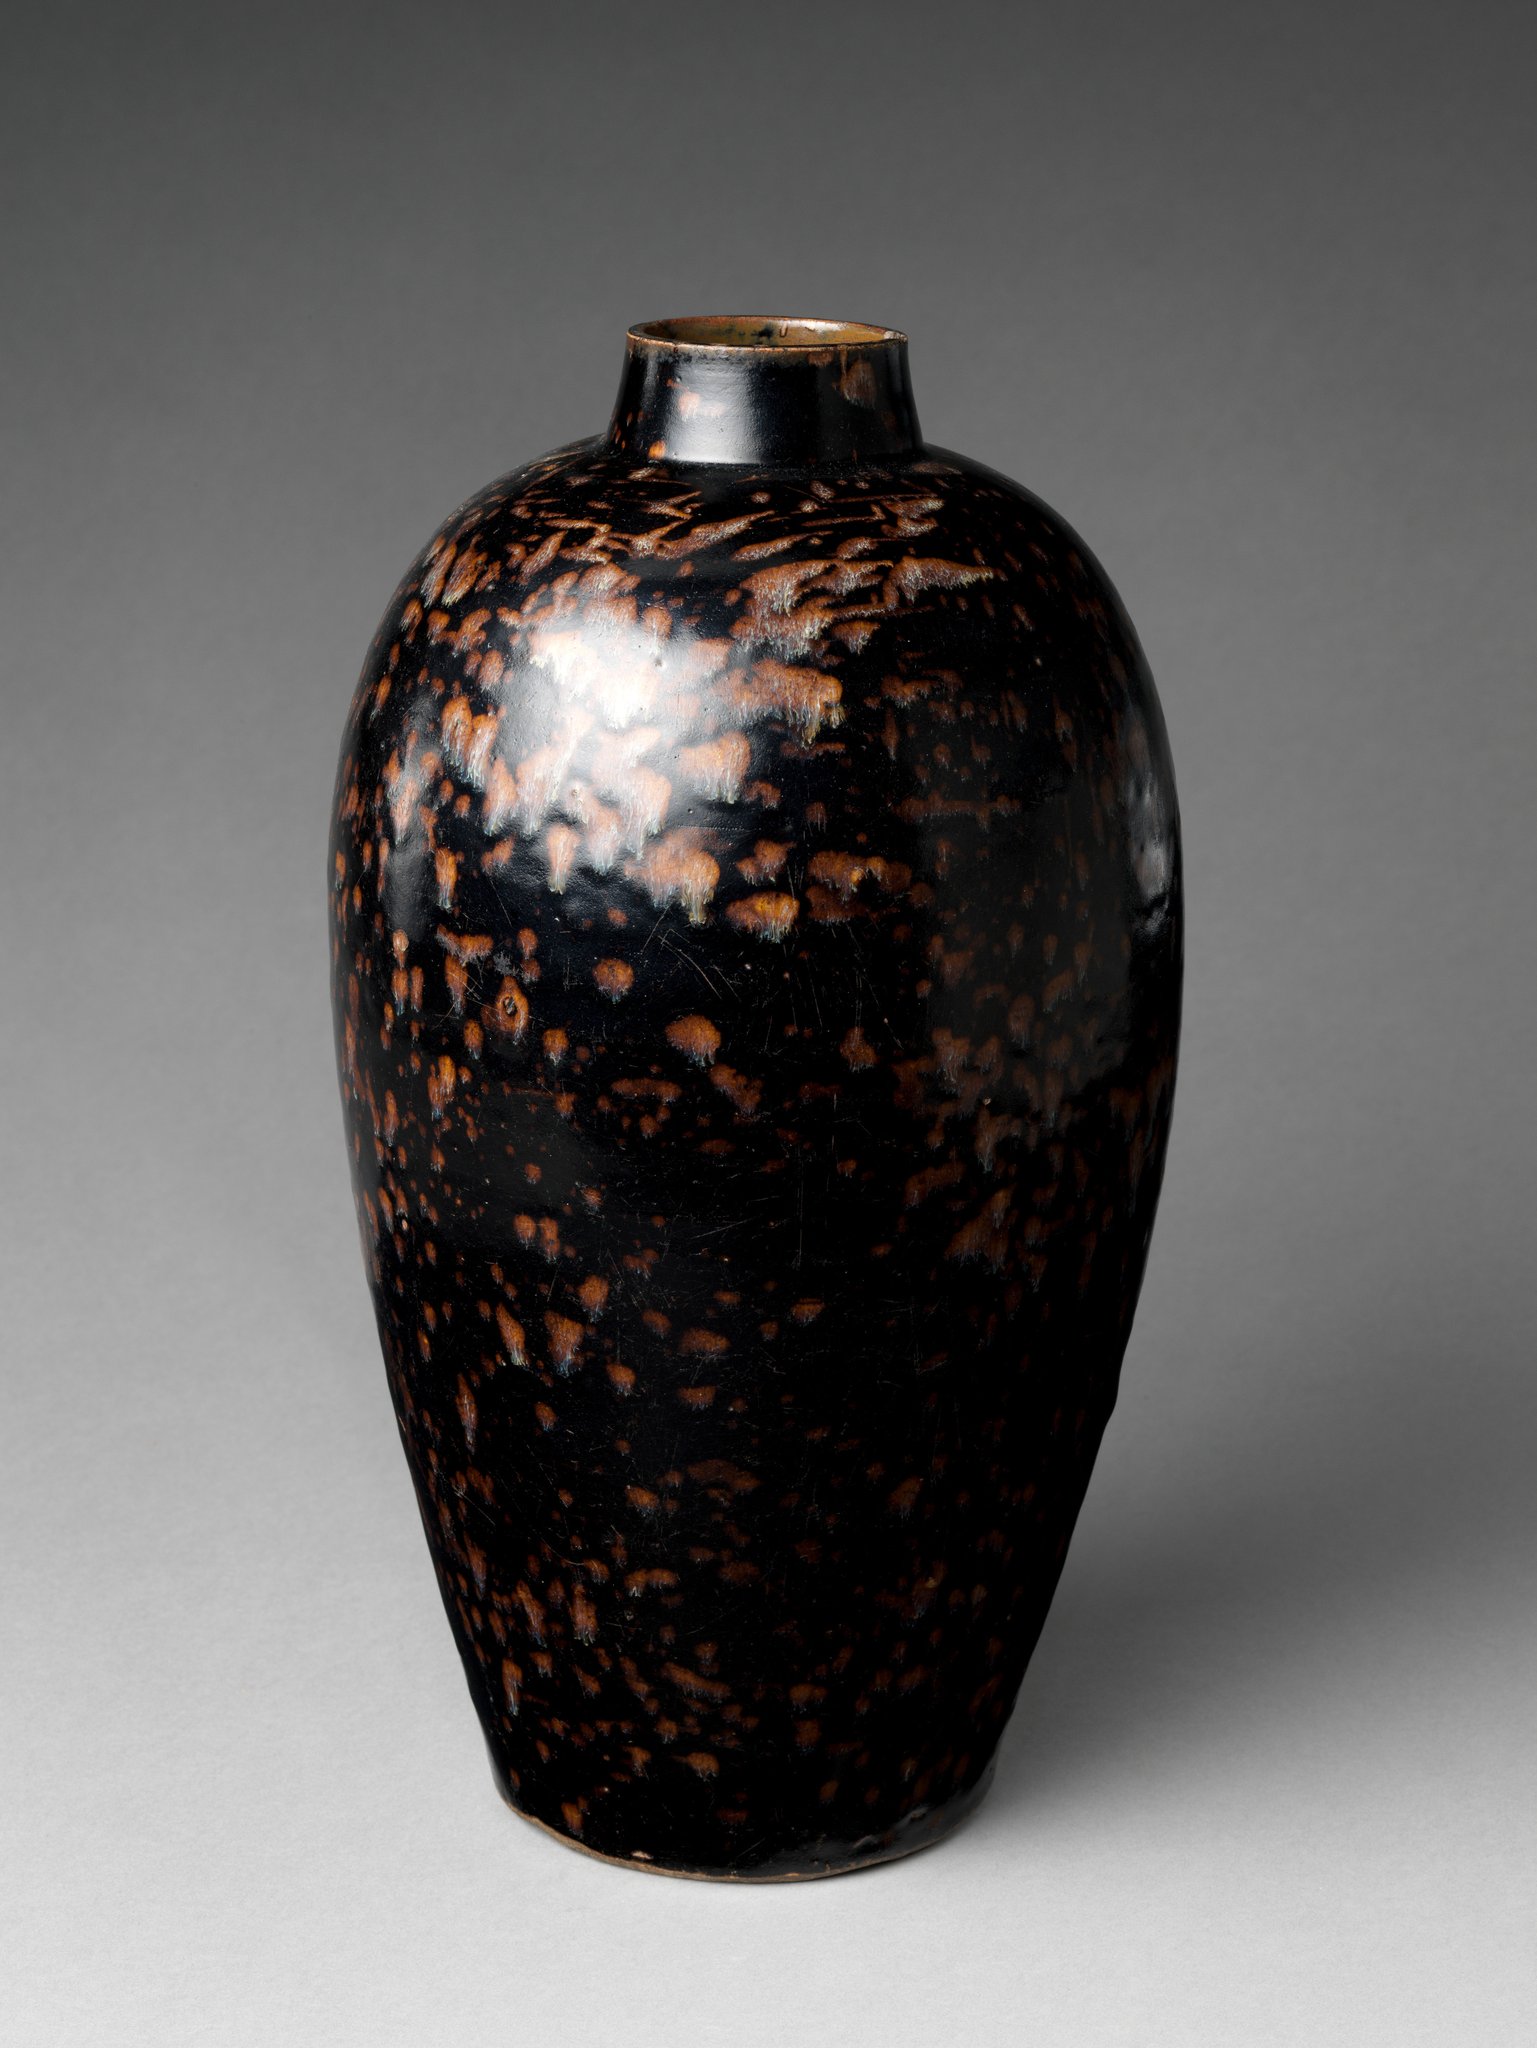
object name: bottle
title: Bottle in Meiping Shape with “Tortoiseshell” Glaze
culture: chinese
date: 1301-1400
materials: glaze, iron, stoneware